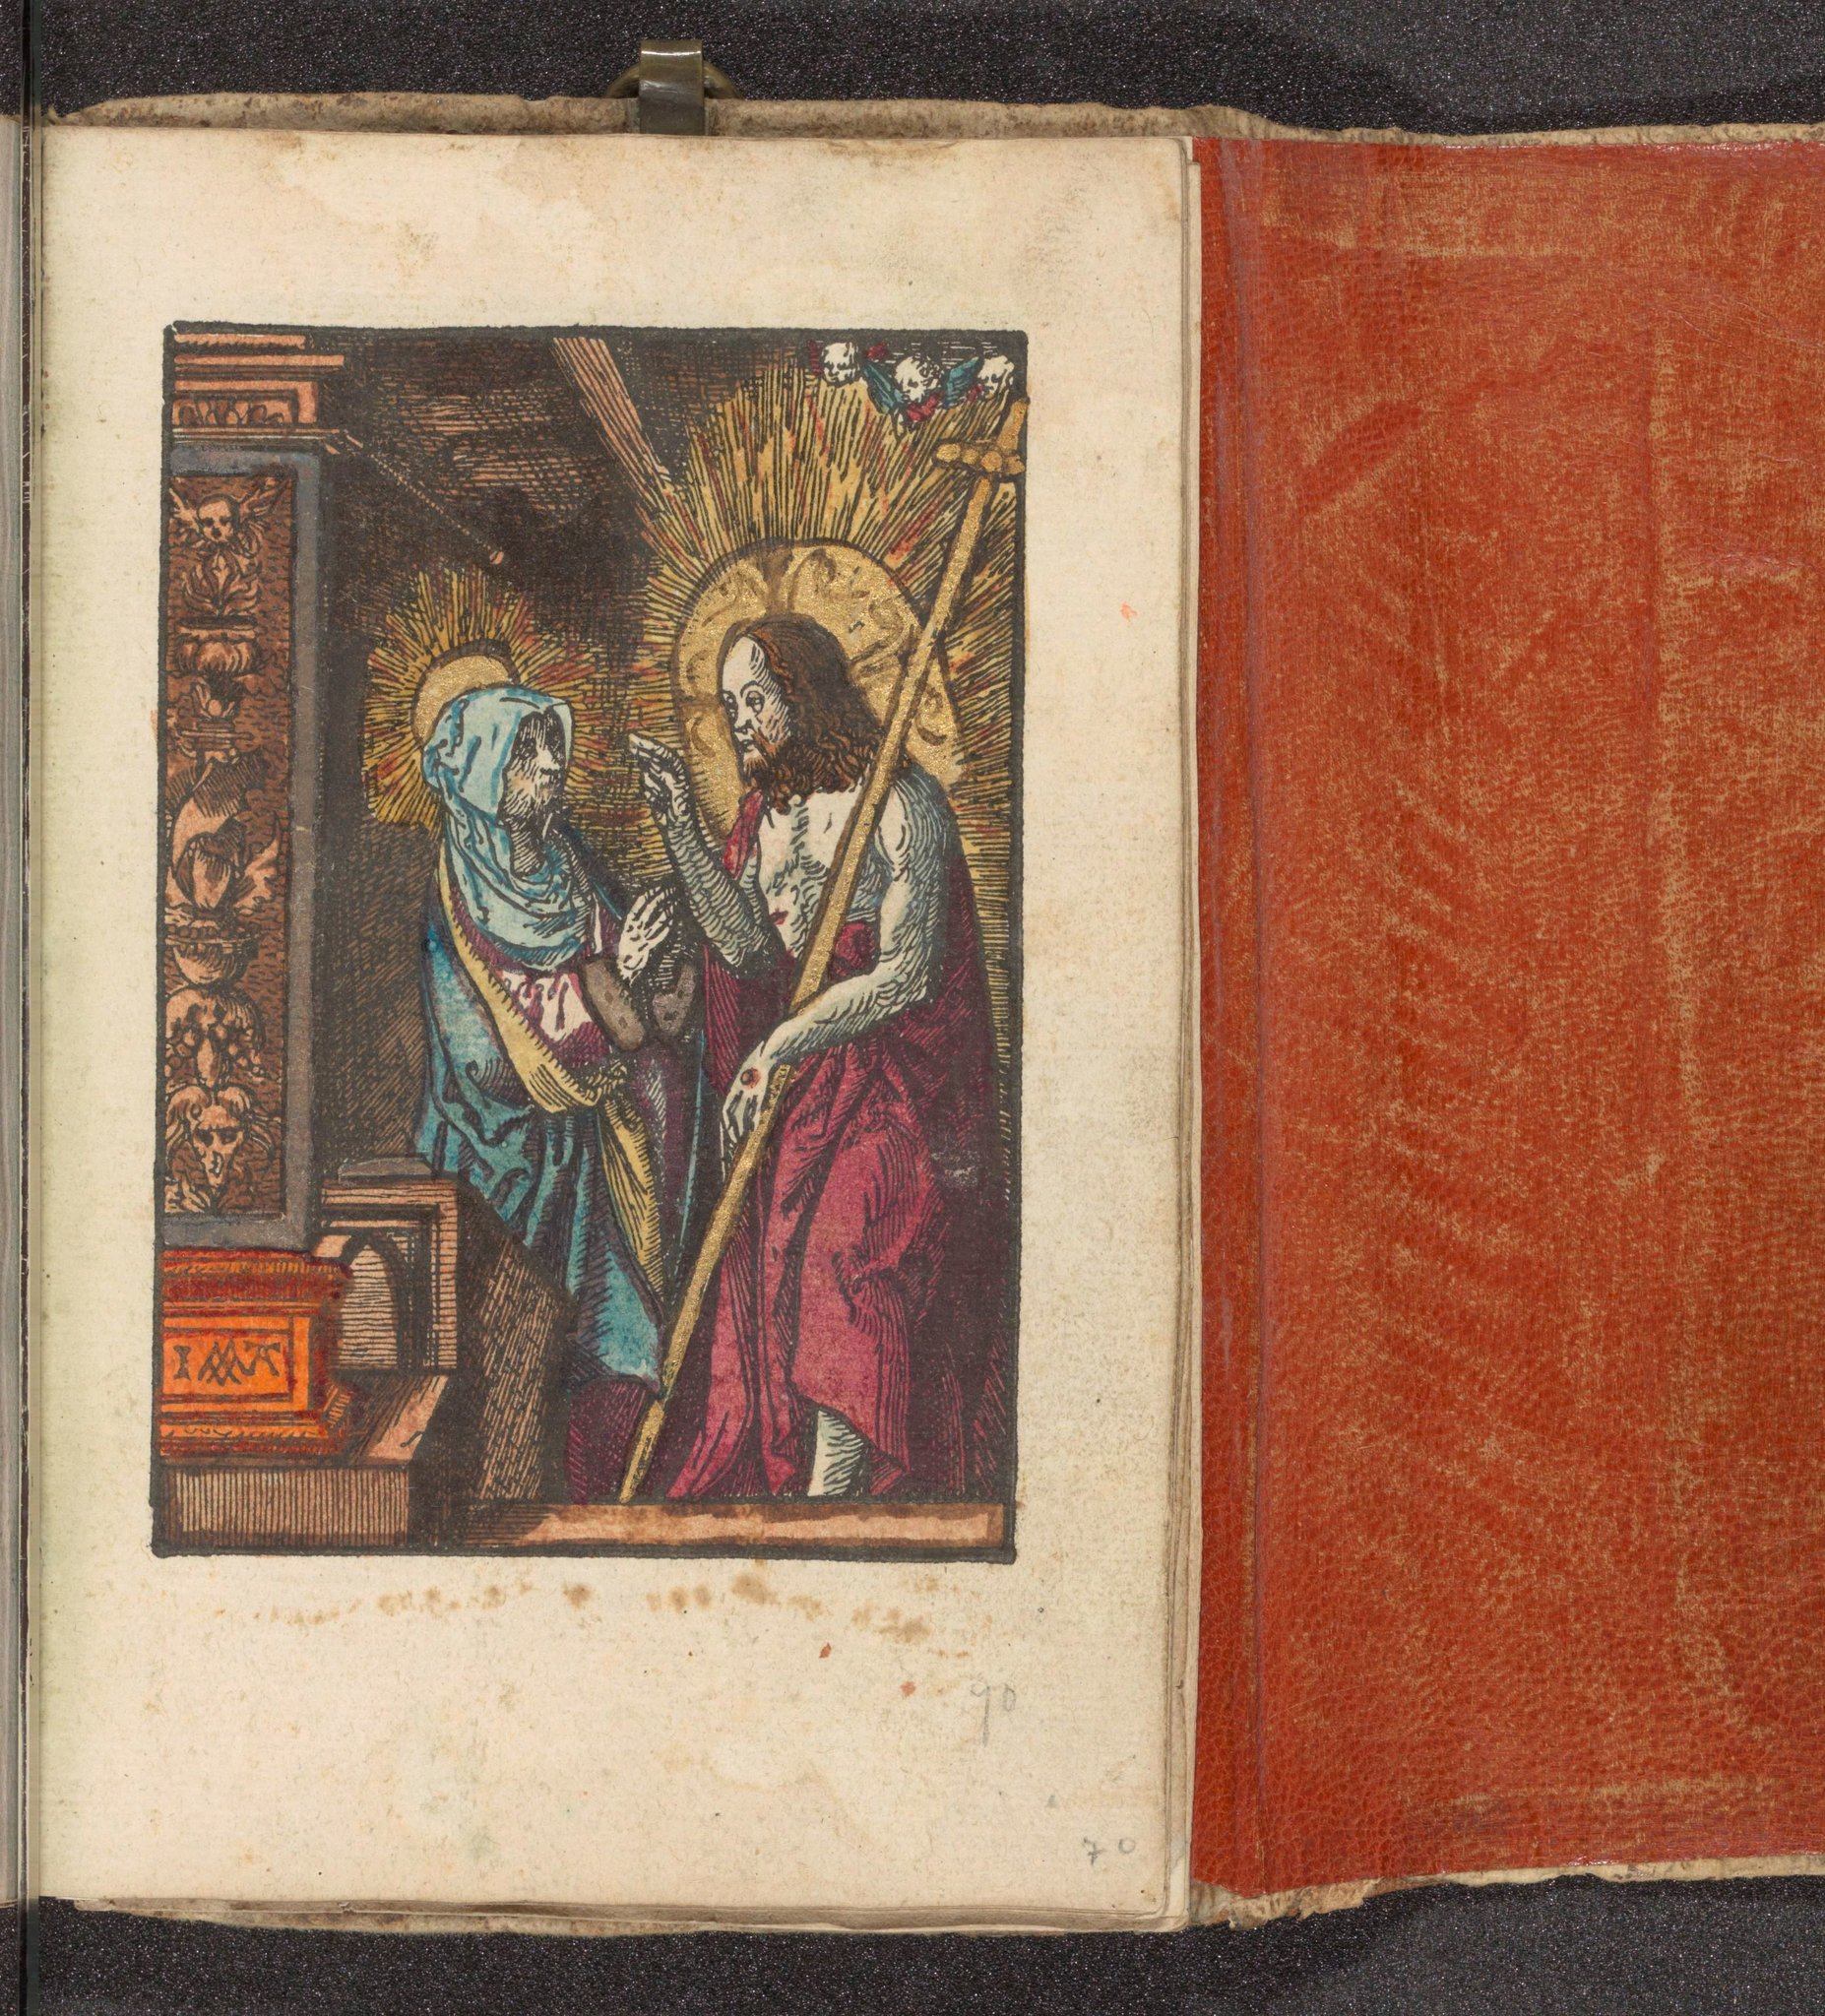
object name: print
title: De kleine Passie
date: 1520-1521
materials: paper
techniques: hand coloring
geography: amsterdam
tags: book in which illustrations are essential, christ, perhaps dressed as a pilgrim, appearing to his mother, who is usually shown praying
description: De opgestane Christus verschijnt aan zijn moeder Maria. Prent maakt deel uit van een boek.